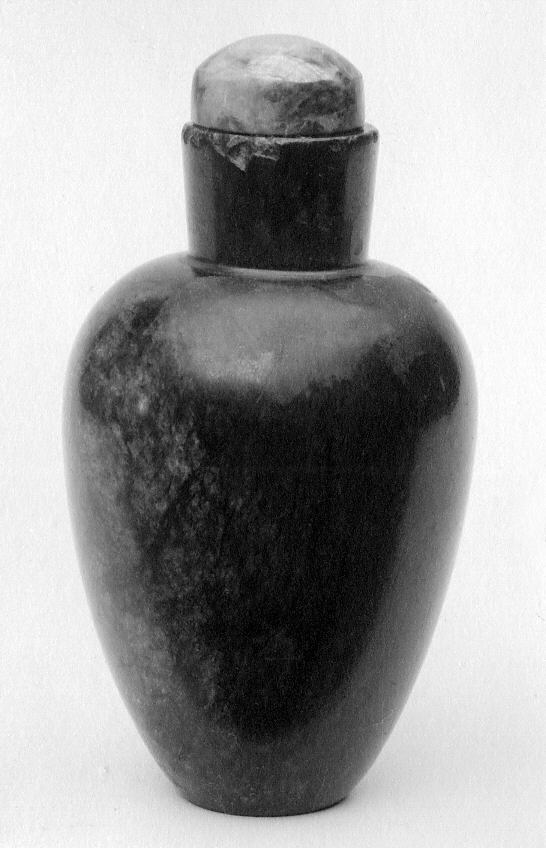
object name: snuff bottle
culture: chinese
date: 1736-1795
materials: jade